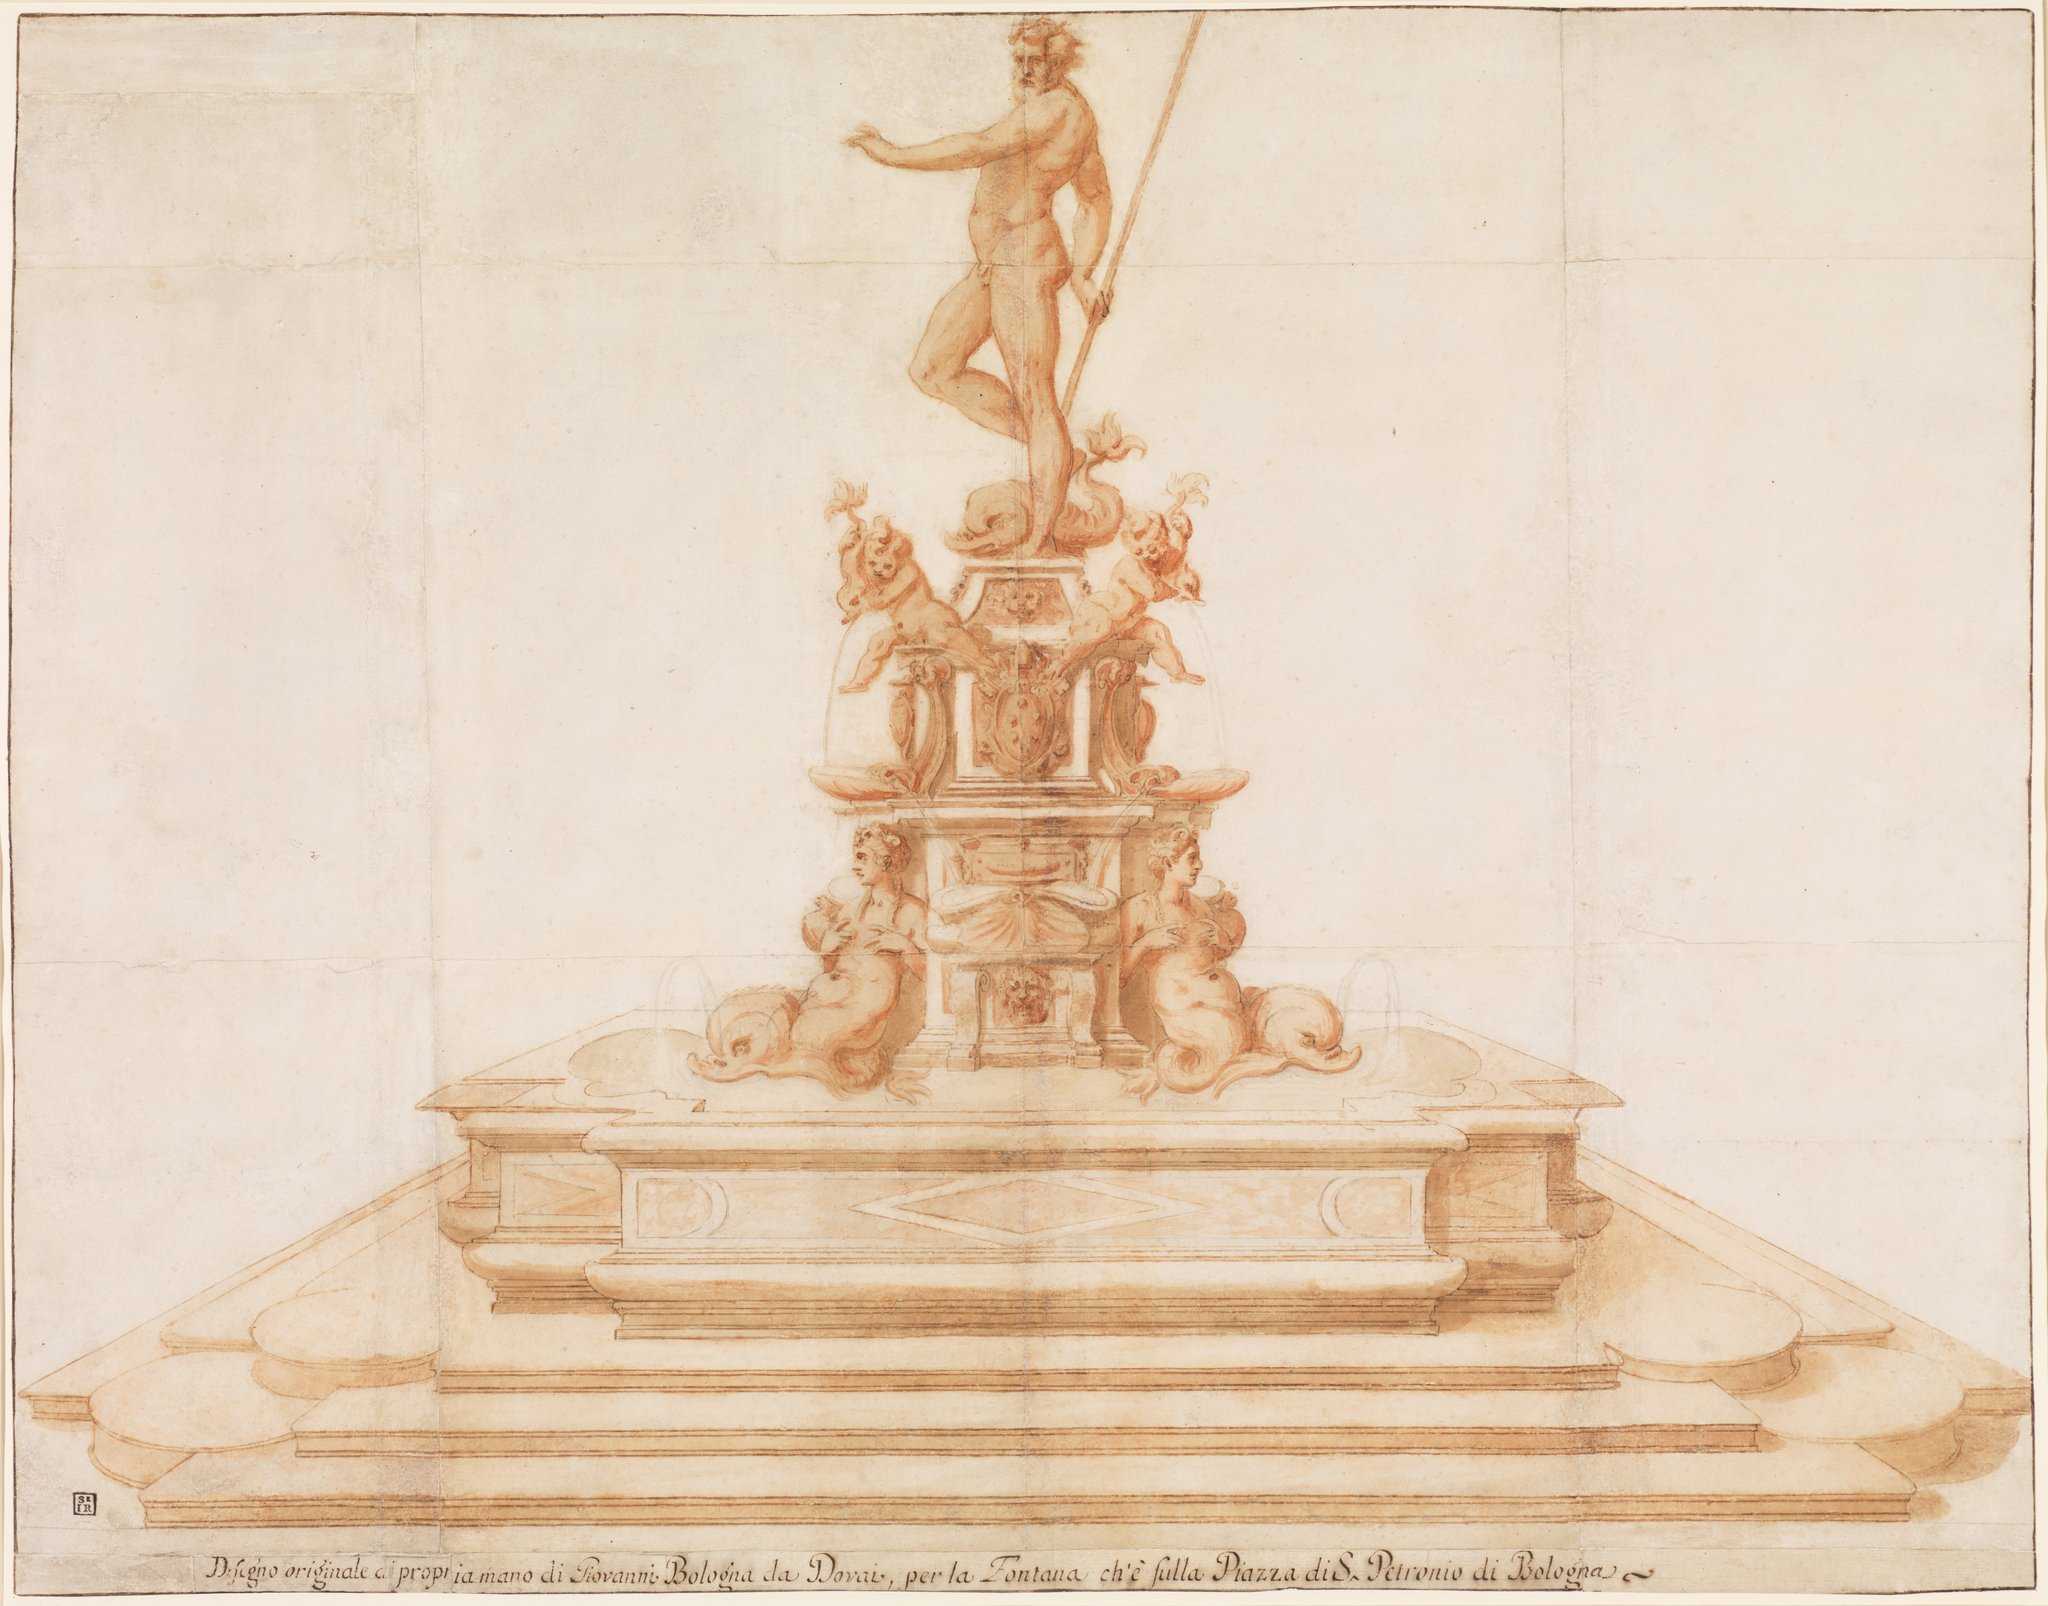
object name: drawing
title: Copy after Giambologna's Neptune Fountain in Piazza San Petronio, Bologna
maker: anonymous, italian, 16th to early 17th century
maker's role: artist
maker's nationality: italian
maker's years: 1500-1640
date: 1600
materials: chalk, ink, paper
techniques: brush, pen, wash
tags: neptune